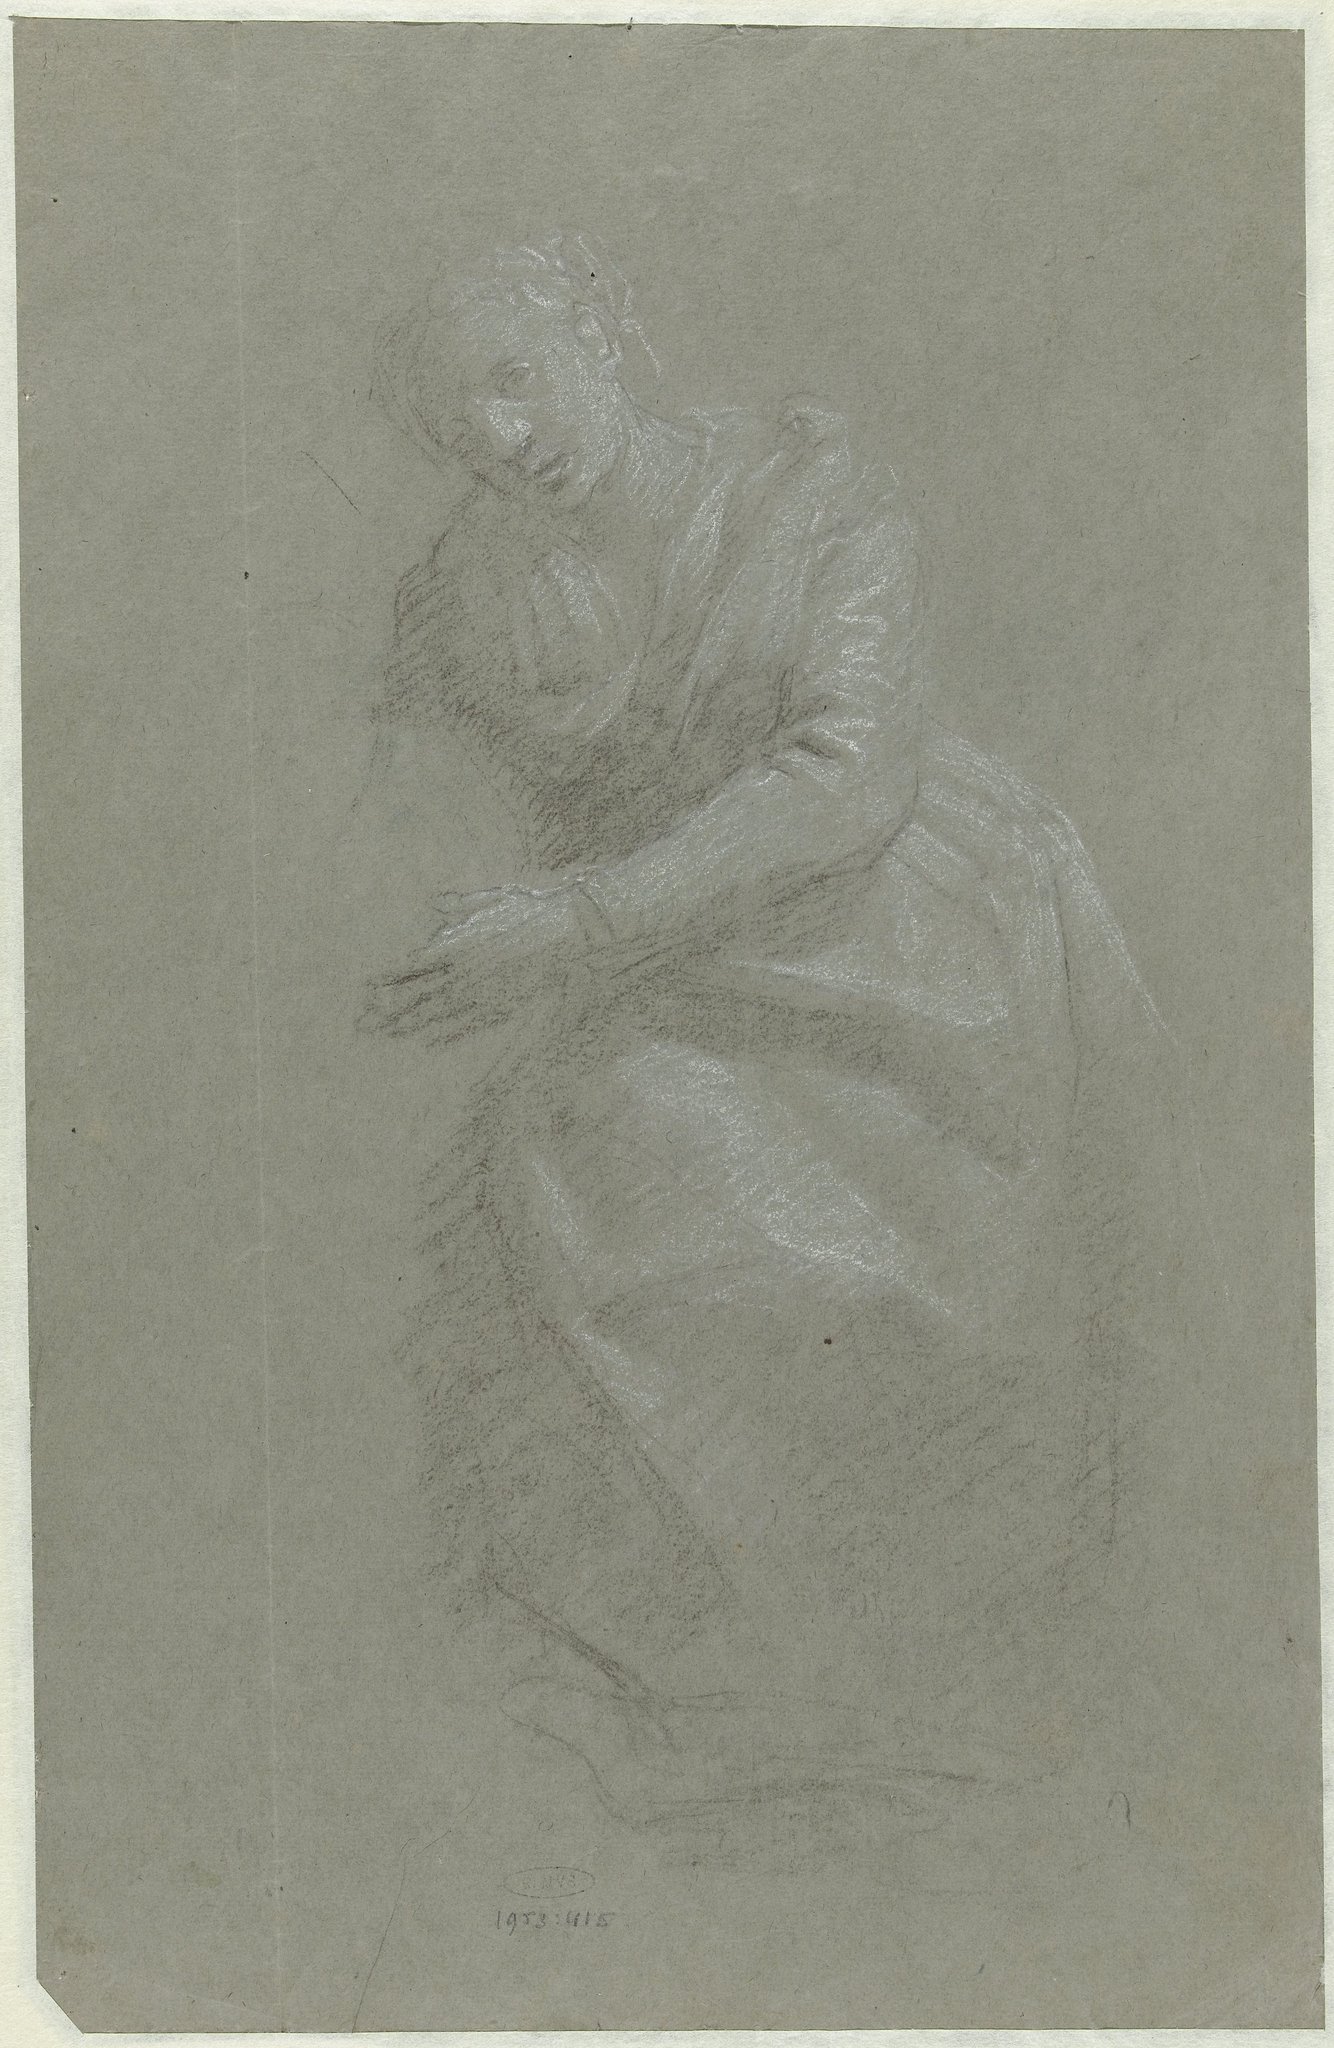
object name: drawing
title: Schetsbladen met figuurstudies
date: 1600-1699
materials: chalk, paper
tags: sitting figure - aa - female human figure, mary sitting or enthroned, the christ-child in front of her in her lap (or in front of her bosom), sitting figures of mary (alone)